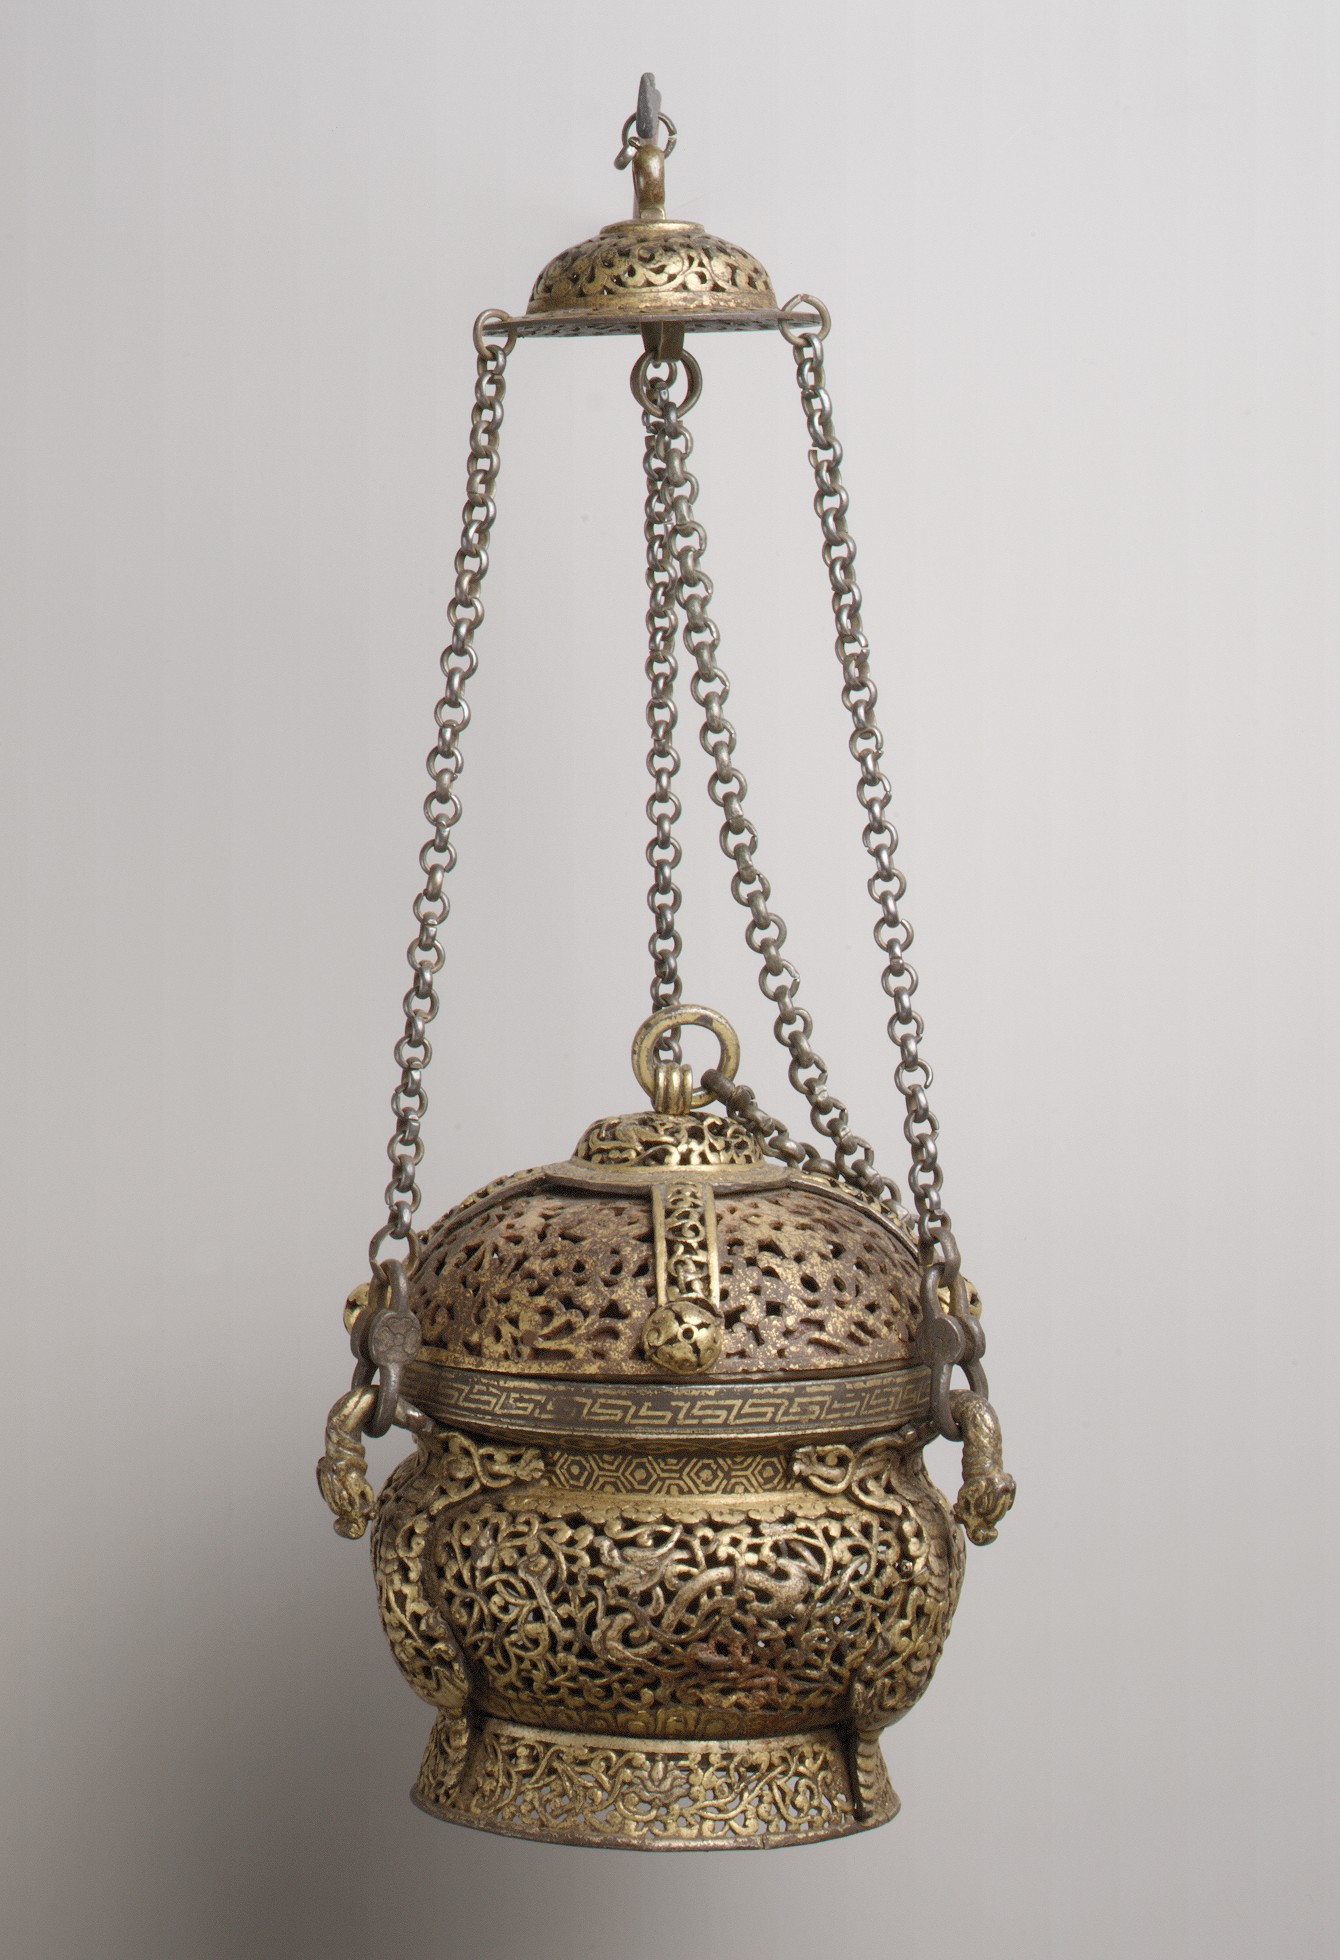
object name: censer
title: Ritual Censer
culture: tibetan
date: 1401-1600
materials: gold, iron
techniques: inlay